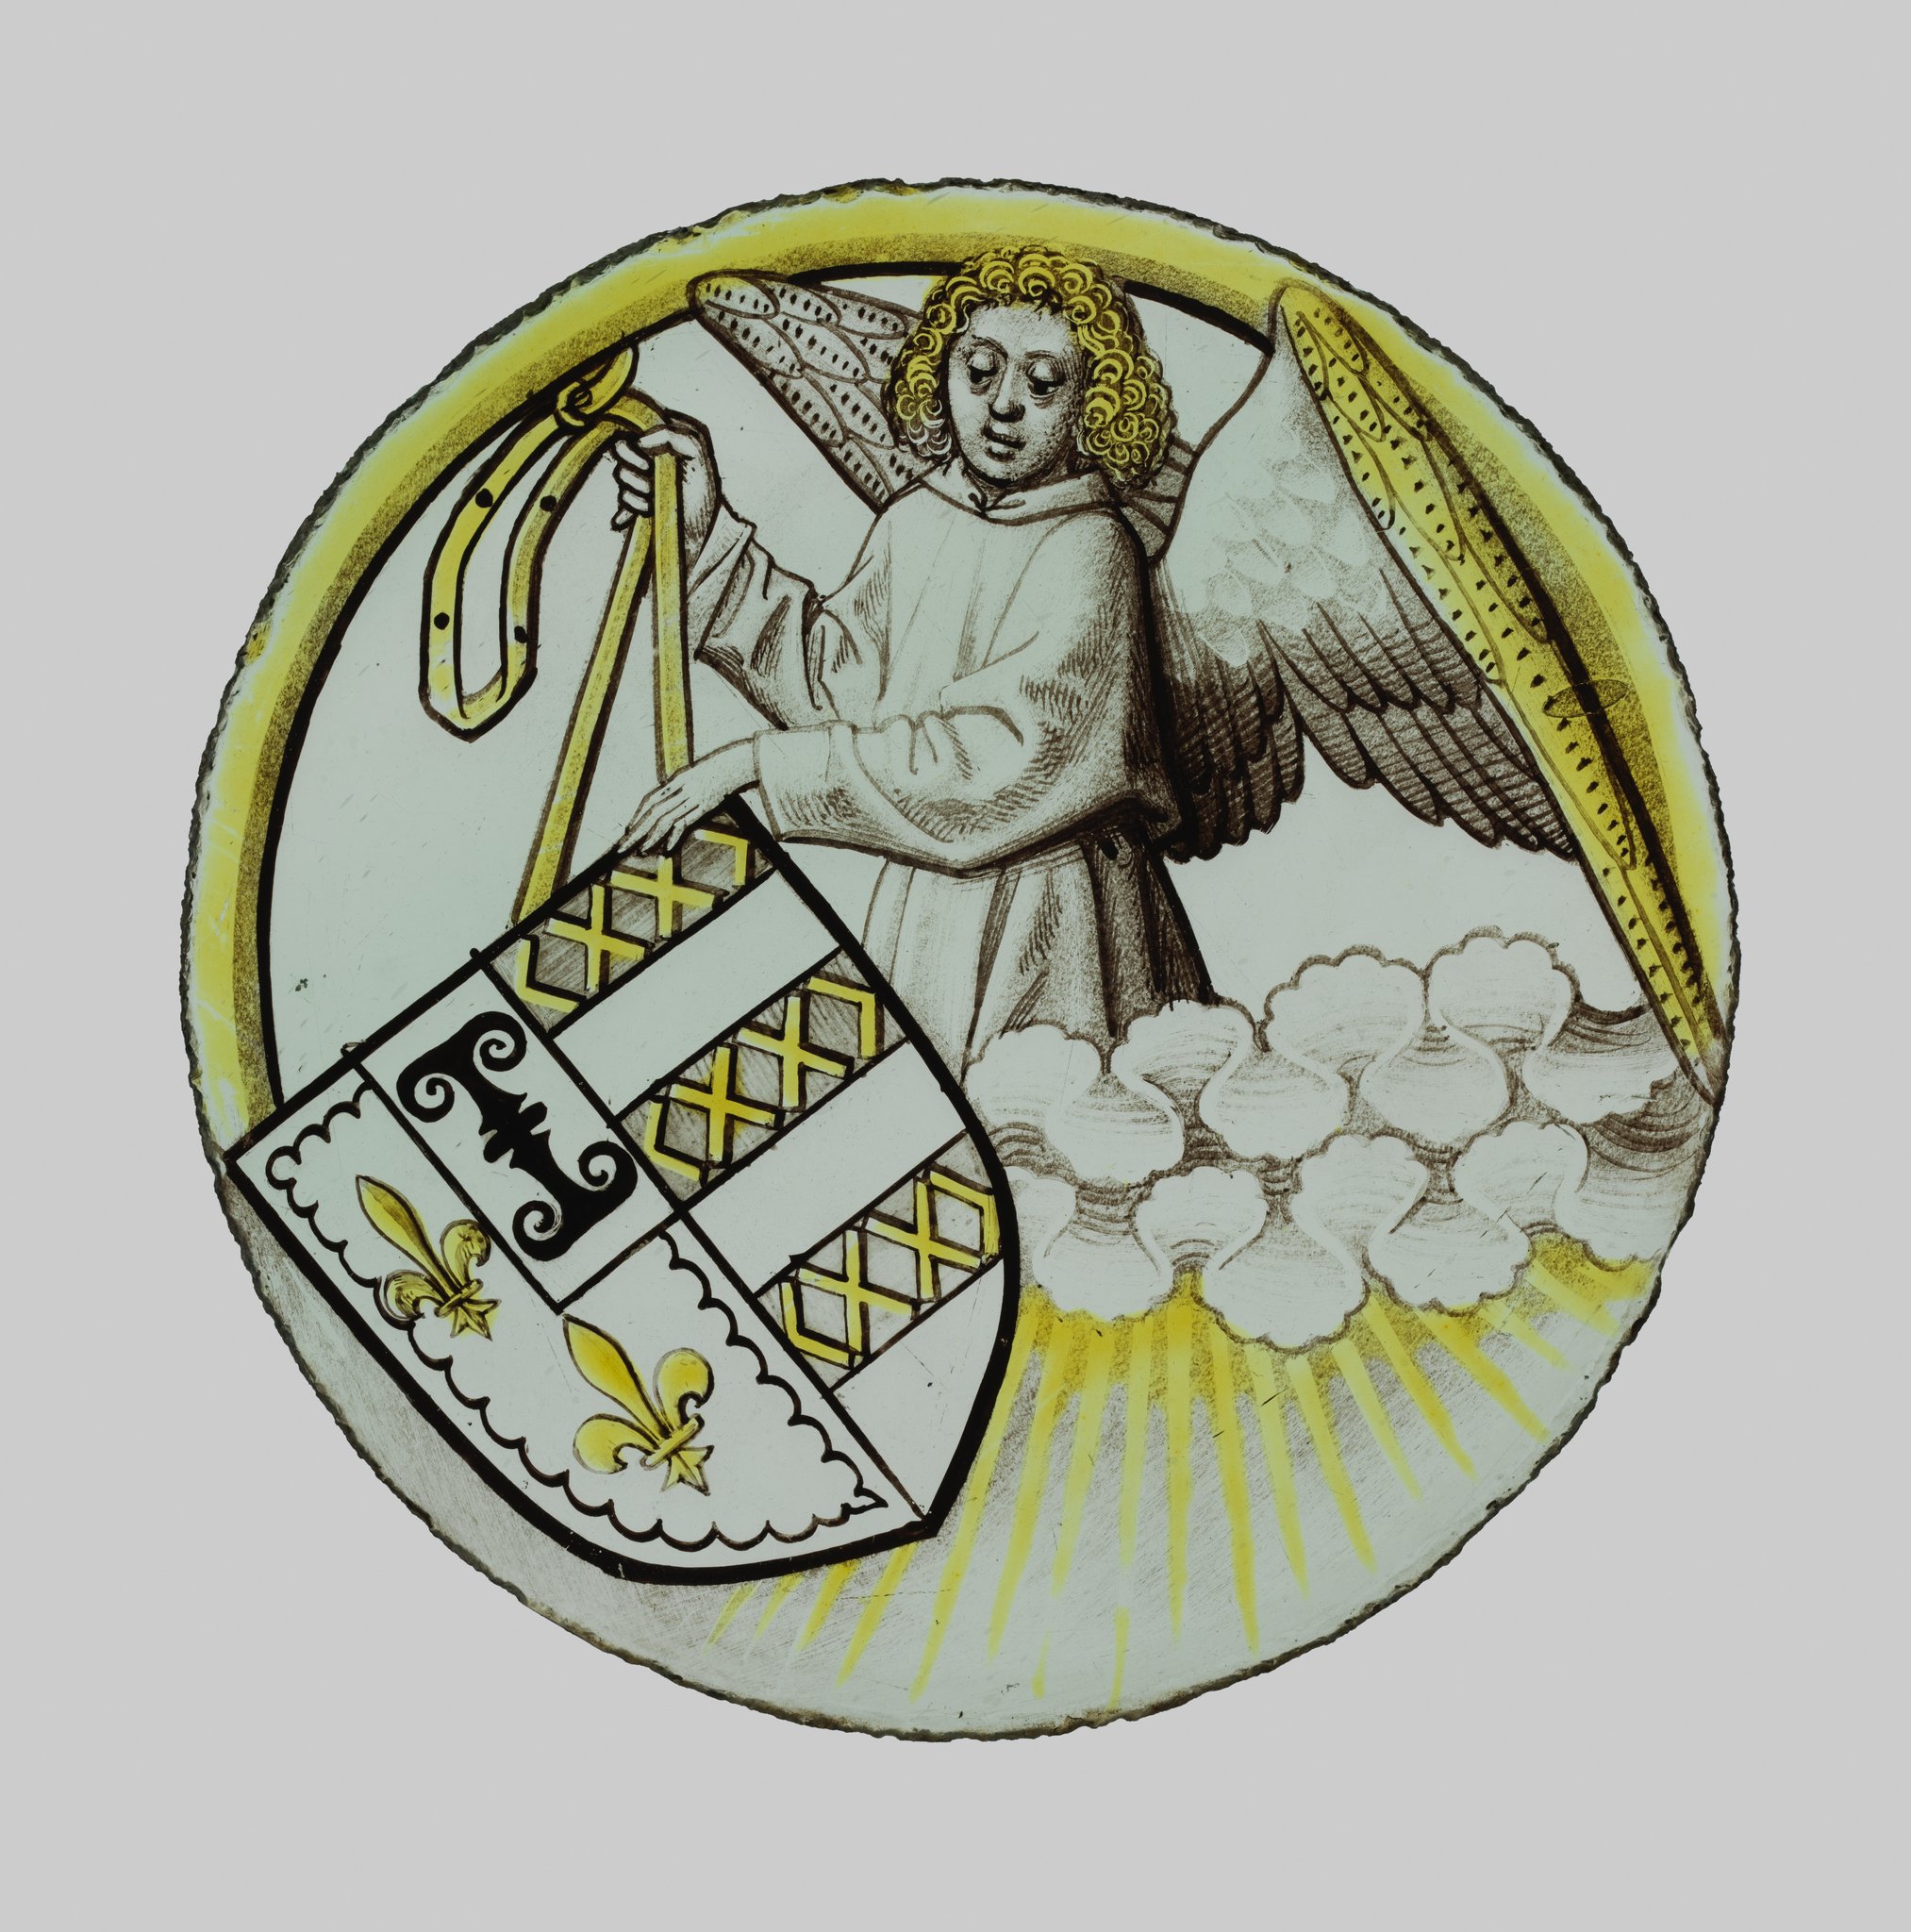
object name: roundel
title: Roundel with Angel Supporting a Heraldic Shield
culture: south netherlandish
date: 1490-1500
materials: glass, paint, pigment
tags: angels,coat of arms